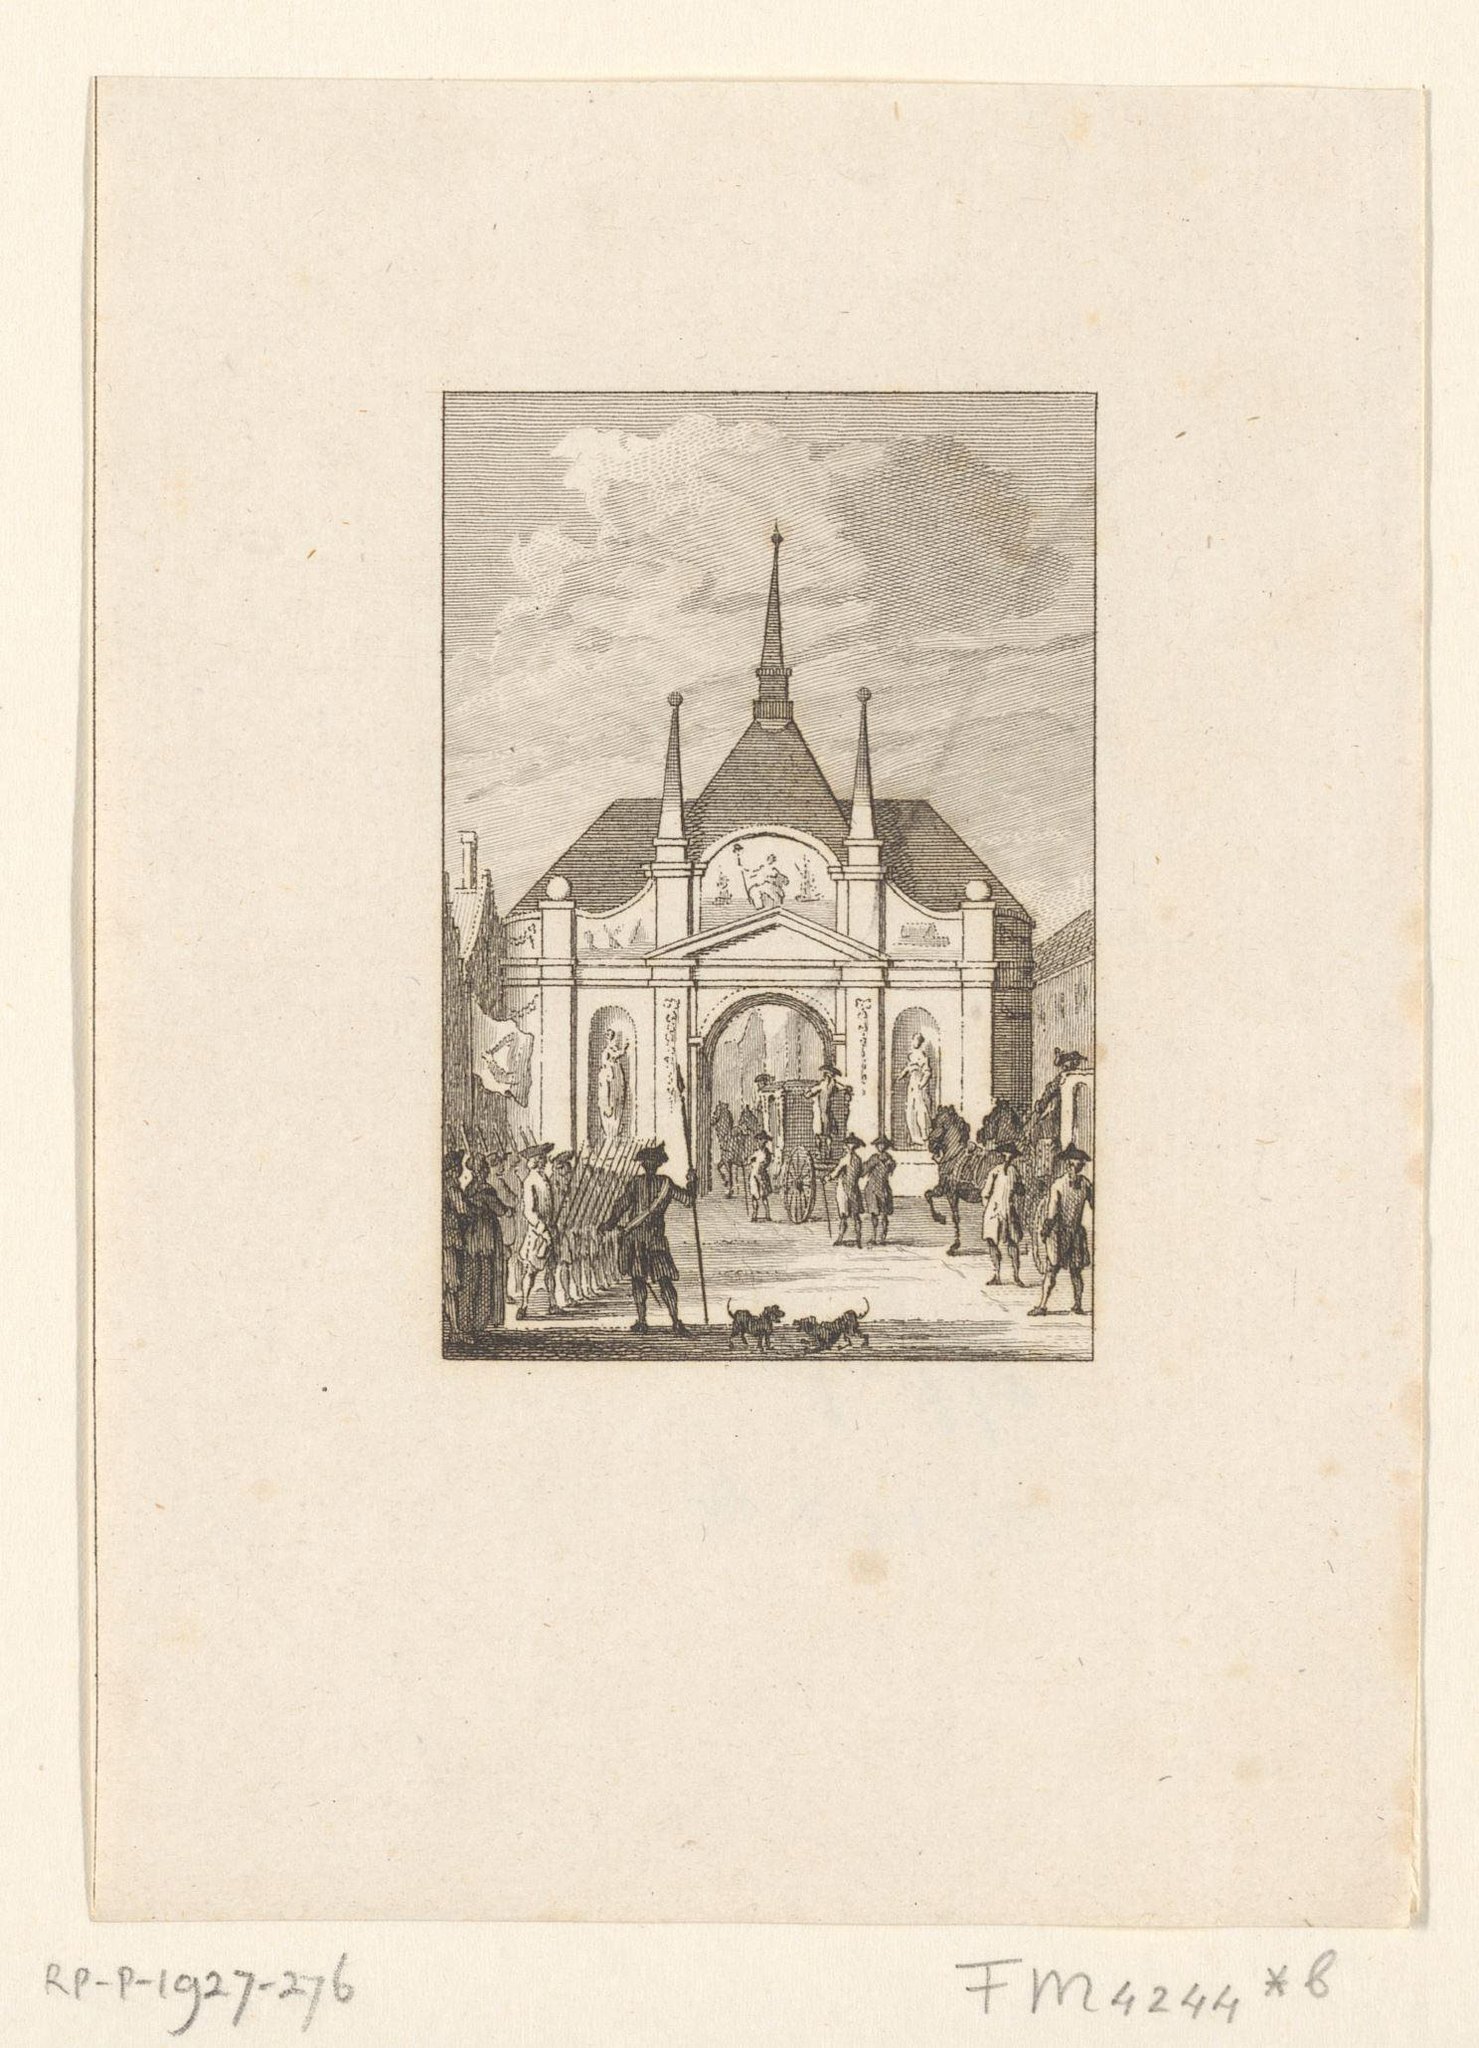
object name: print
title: Triomfpoort ter ere van 200 jaar vrijheid in Vlissingen, 1772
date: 1780-1795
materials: paper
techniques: etching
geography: northern netherlands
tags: triumphal arch, flushing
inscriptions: collector's mark: Lugt 2228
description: Triomfpoort opgericht in de stad bij de viering van 200 jaar vrijheid in Vlissingen, 6 april 1772. Rijtuigen rijden door de erepoort of tempel. Gemerkt rechtsboven: XIII.D.Pl.III.